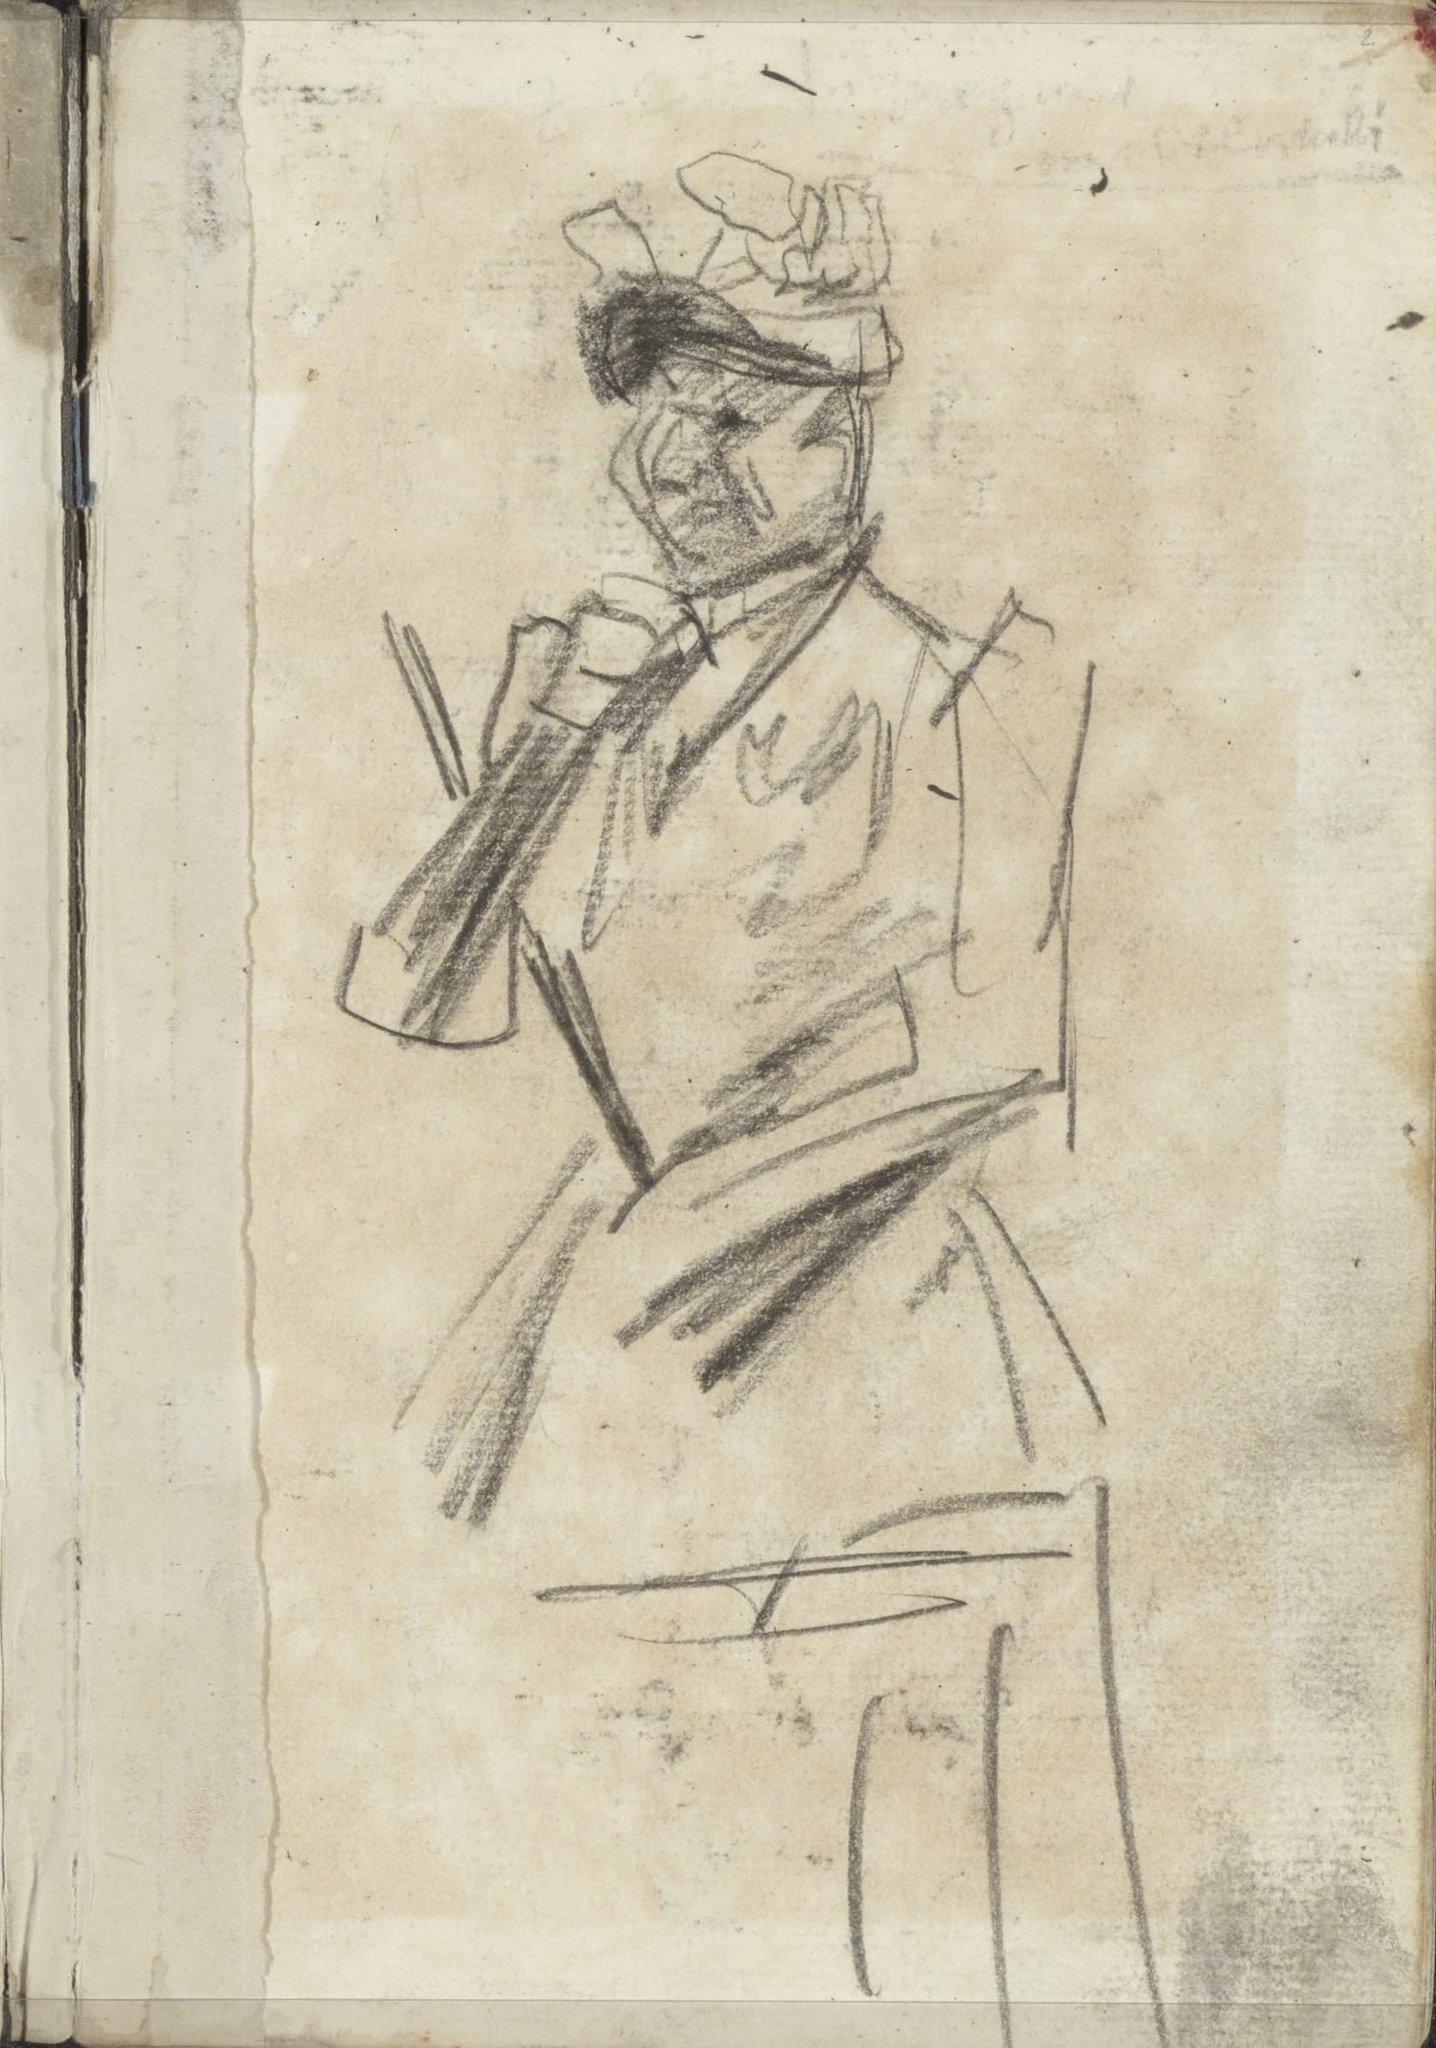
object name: sketchbook leaf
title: Staande vrouw met hoed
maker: george hendrik breitner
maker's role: draughtsman, painter, print maker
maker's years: 1857-1923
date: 1886-1898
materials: chalk, paper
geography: amsterdam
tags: adult woman, standing figure - aa - female human figure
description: Pagina 2 uit een schetsboek met 21 bladen.